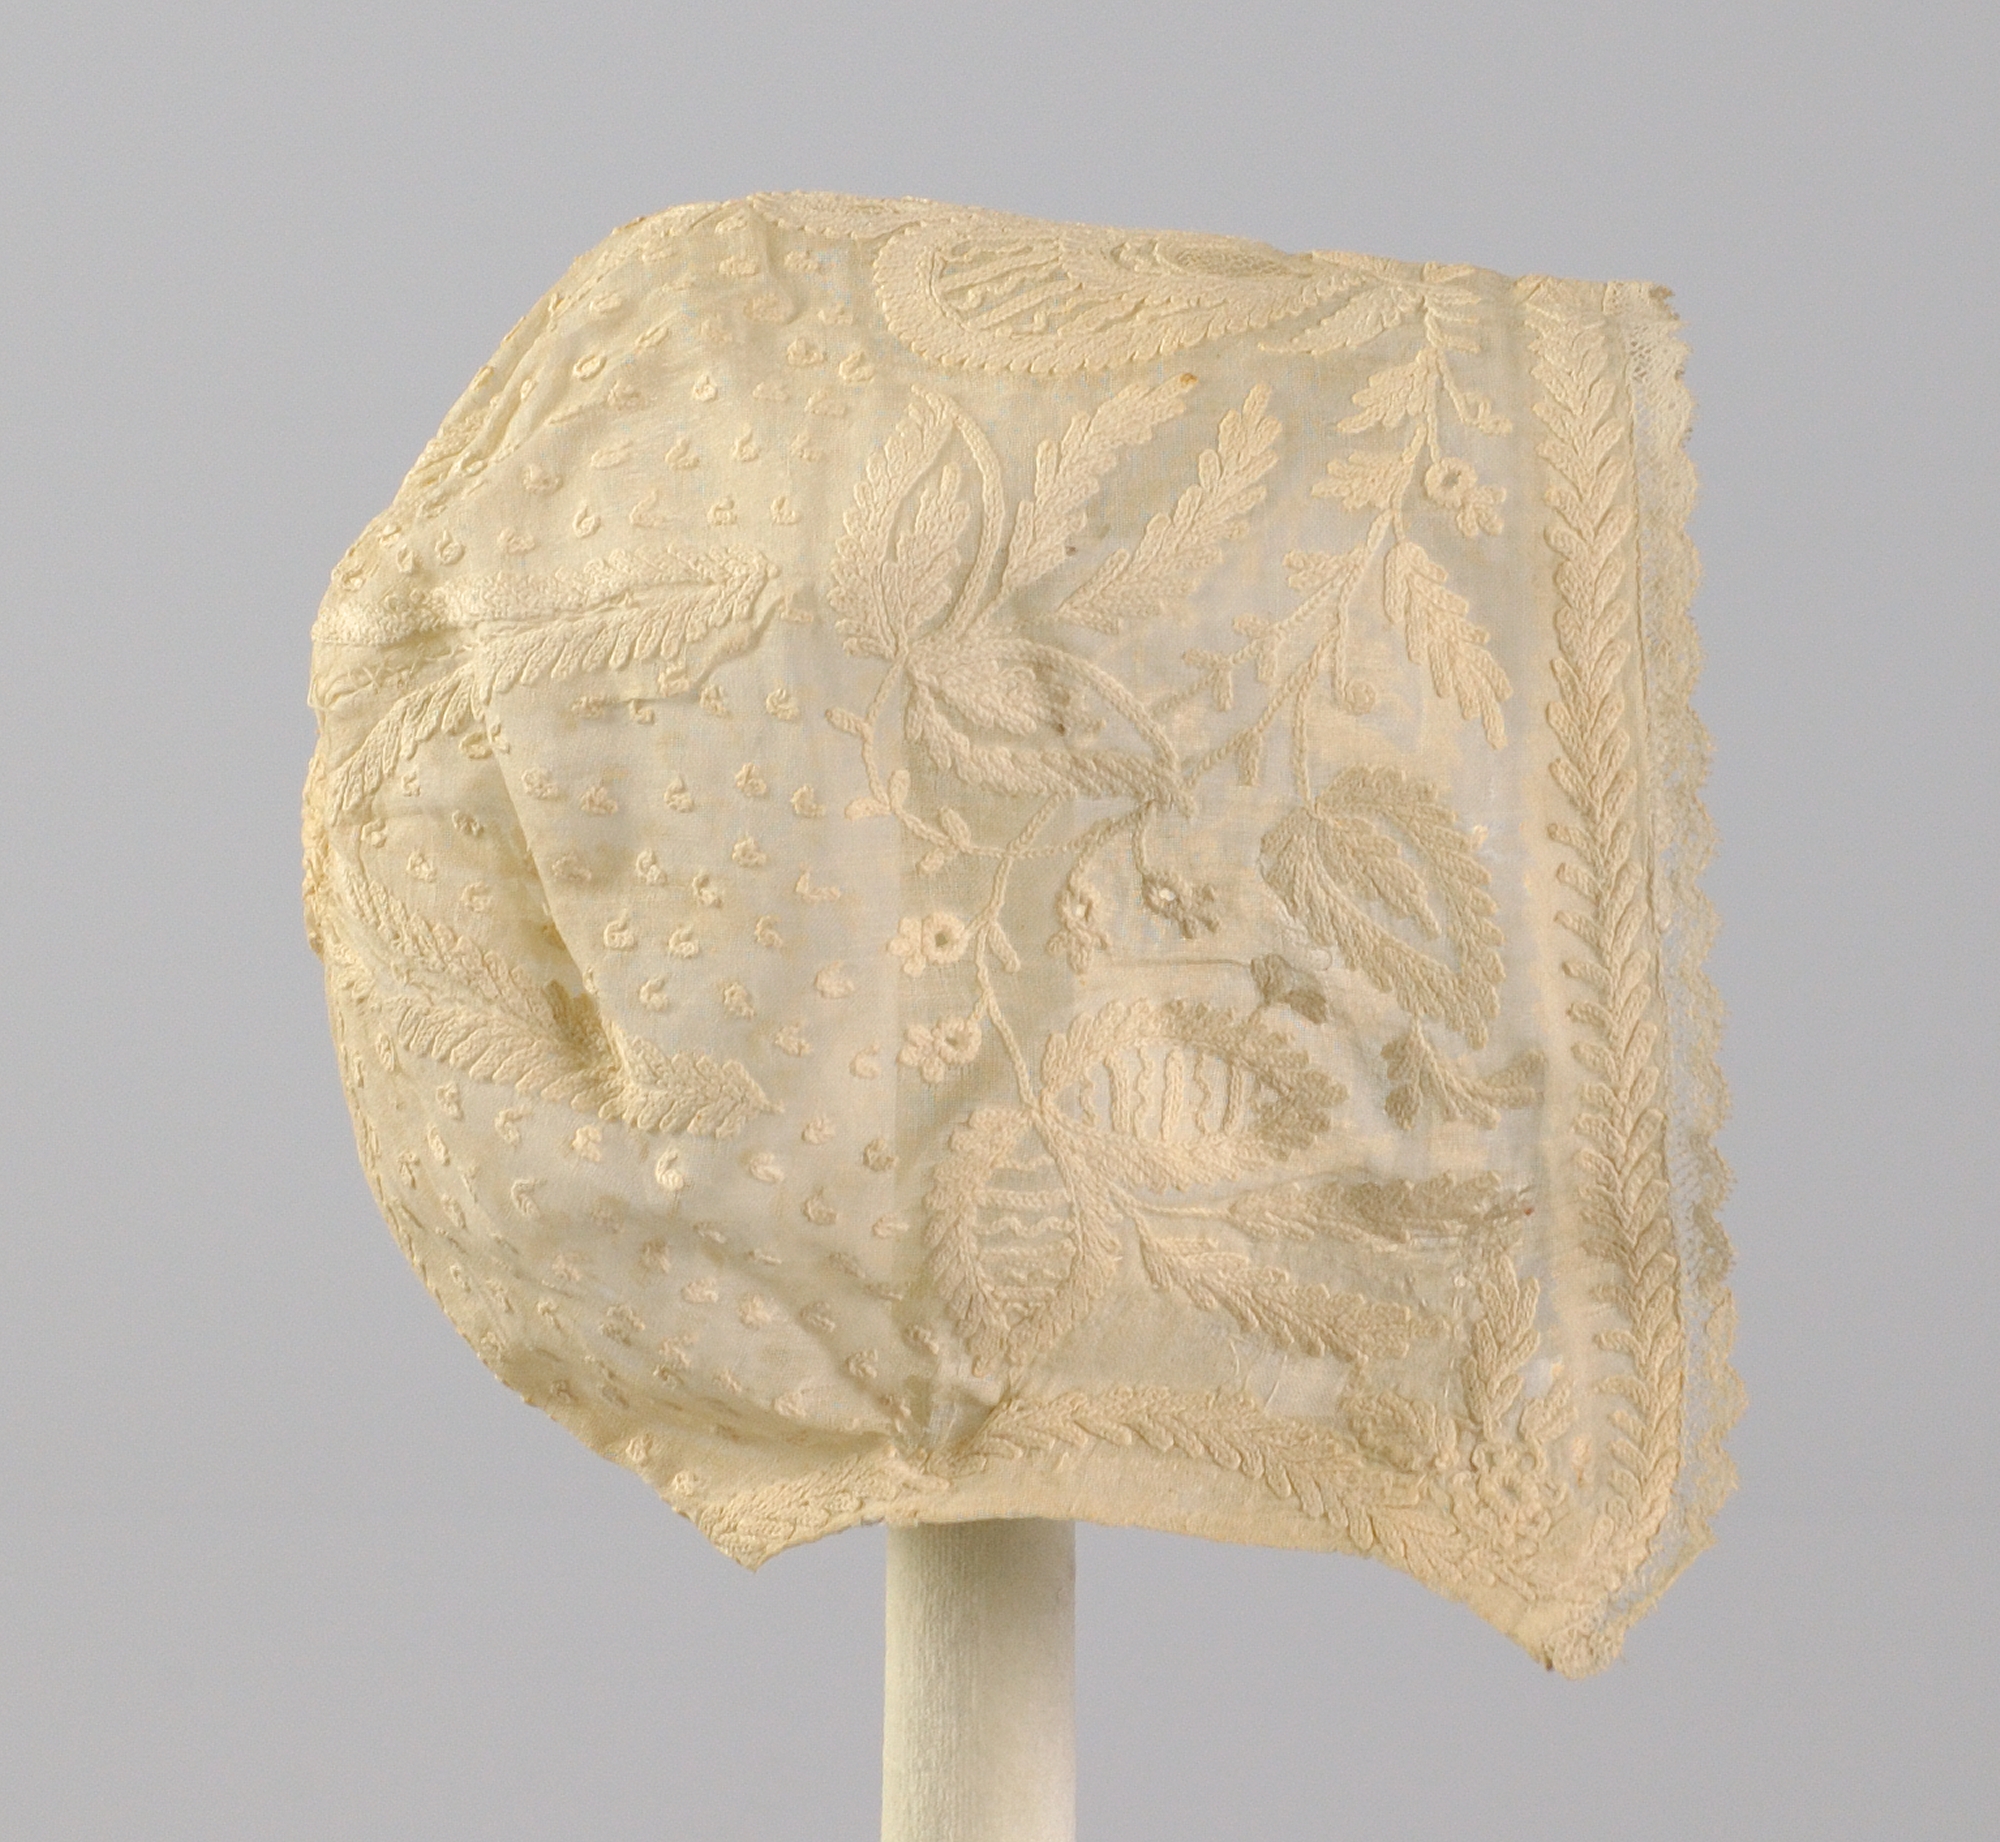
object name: cap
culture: american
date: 1854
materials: cotton, linen